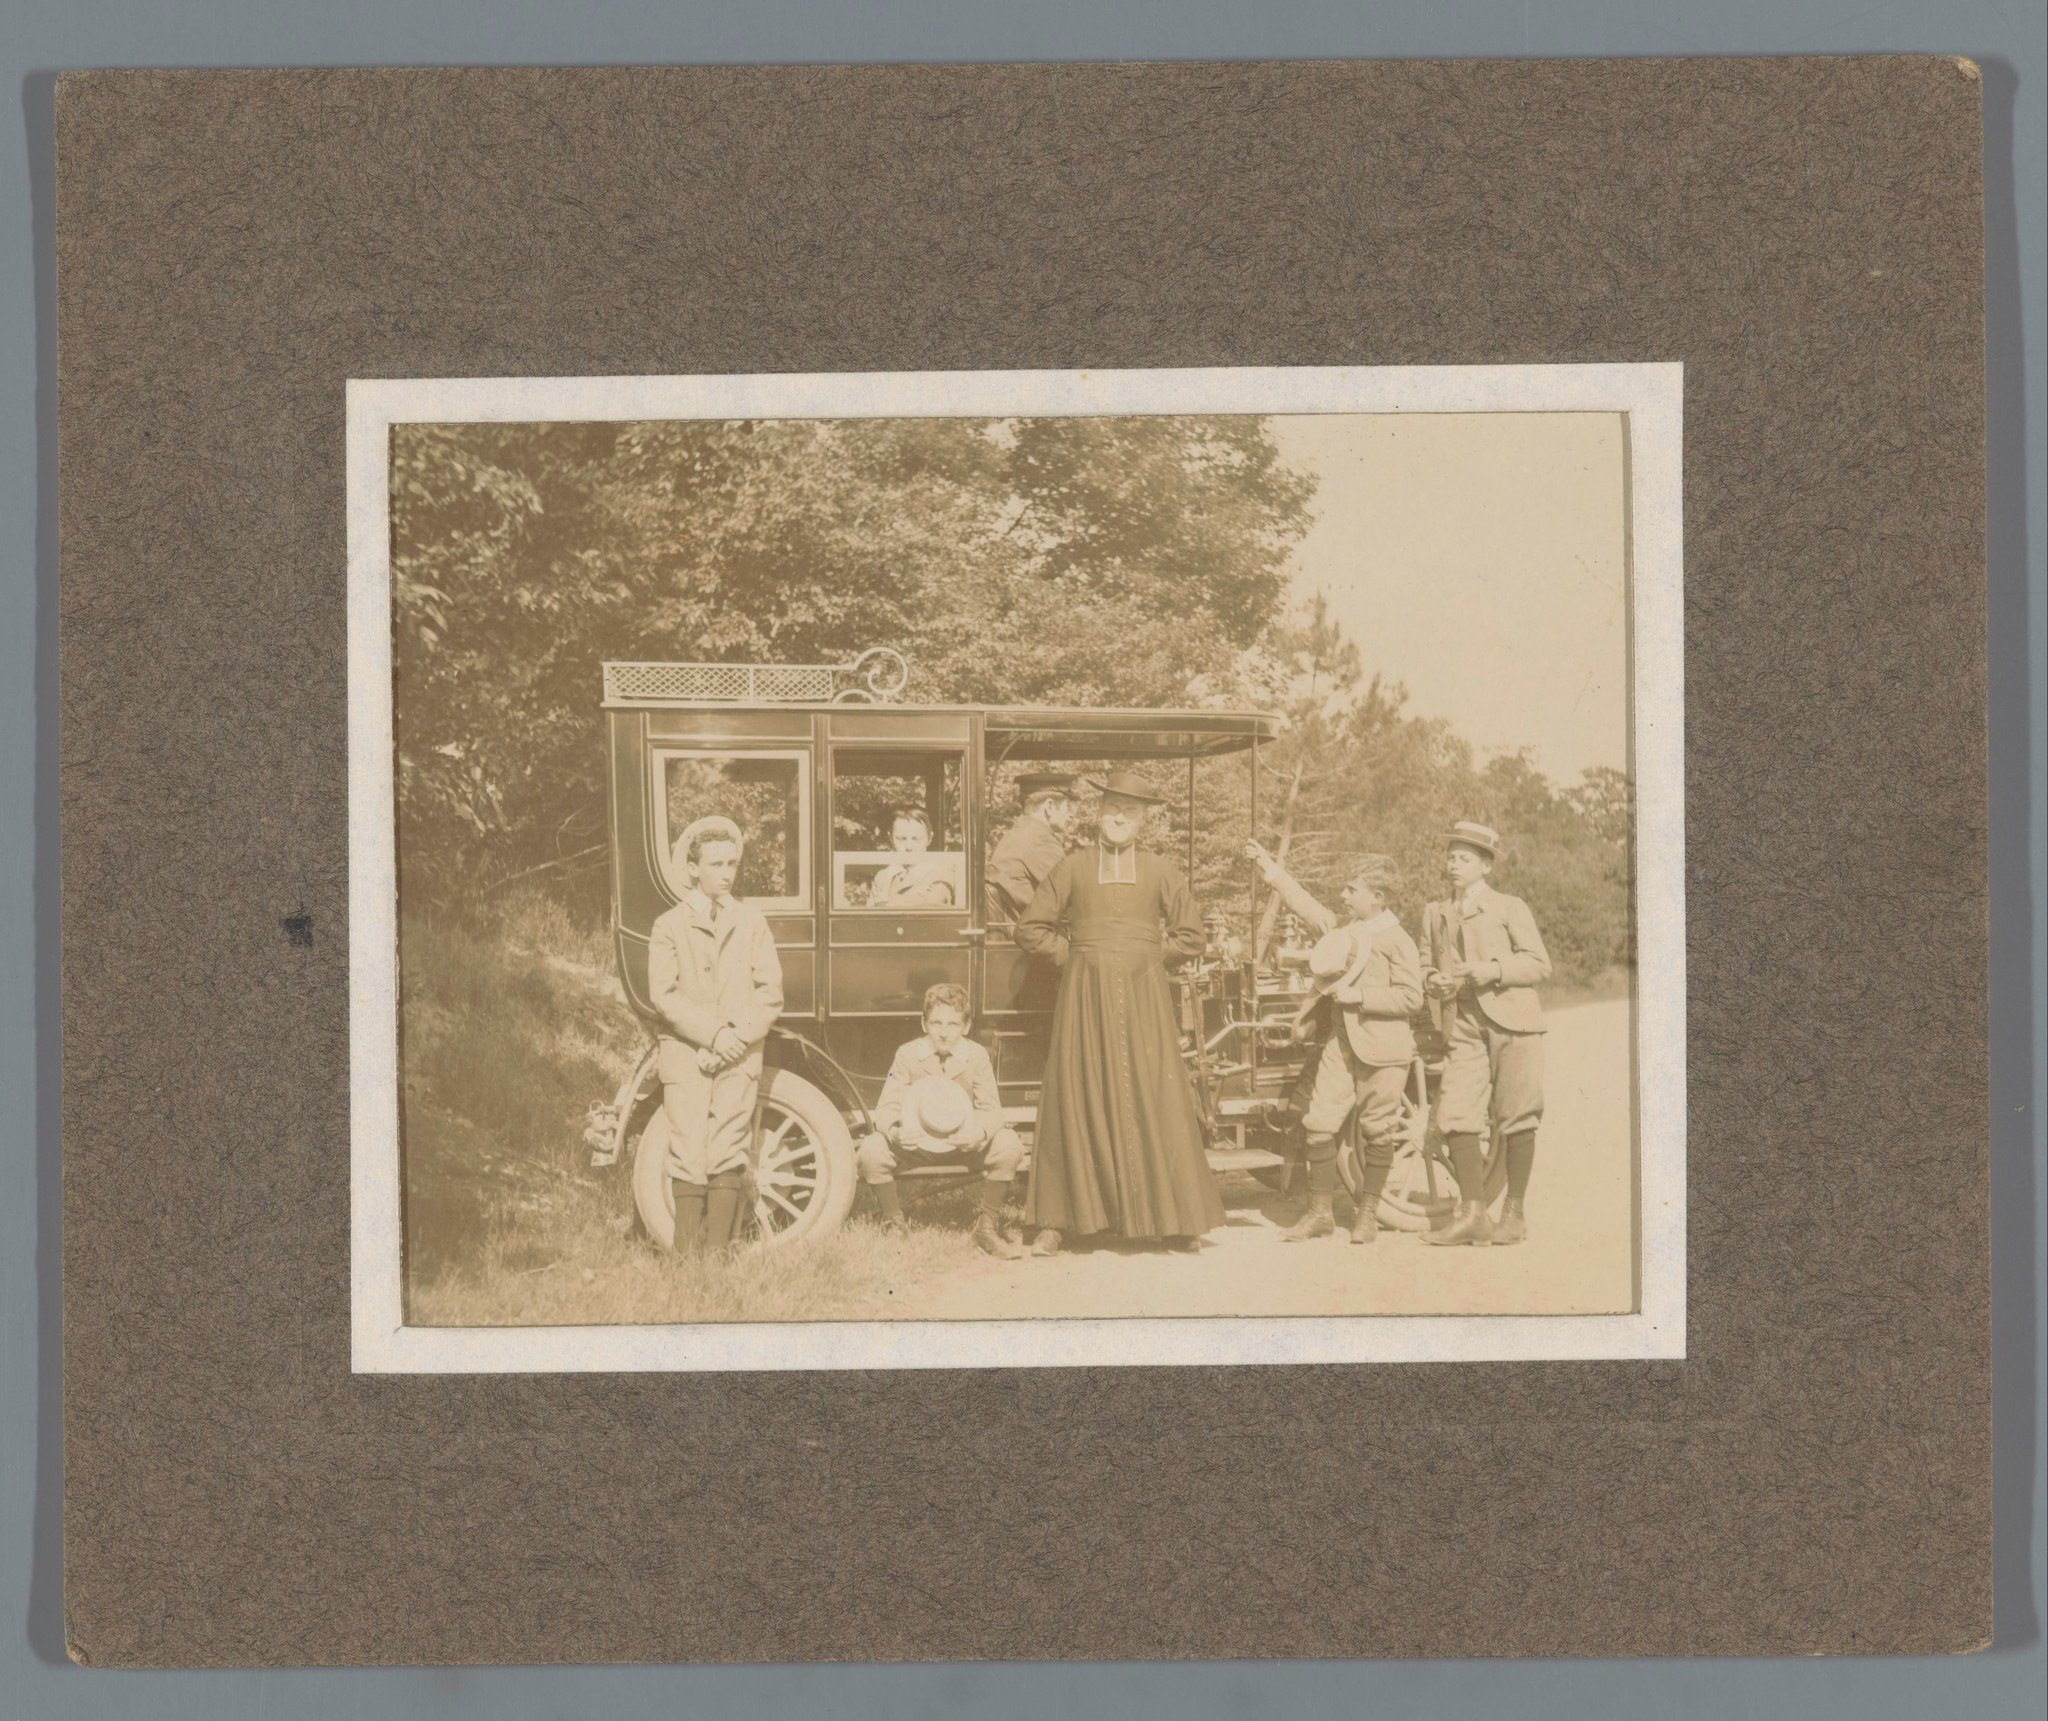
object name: photograph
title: Portret van een priester en vijf jongens rond een auto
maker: Anonymous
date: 1895-1910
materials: photographic support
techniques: gelatin silver print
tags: priest (roman catholic), boy (child between toddler and youth), automobile